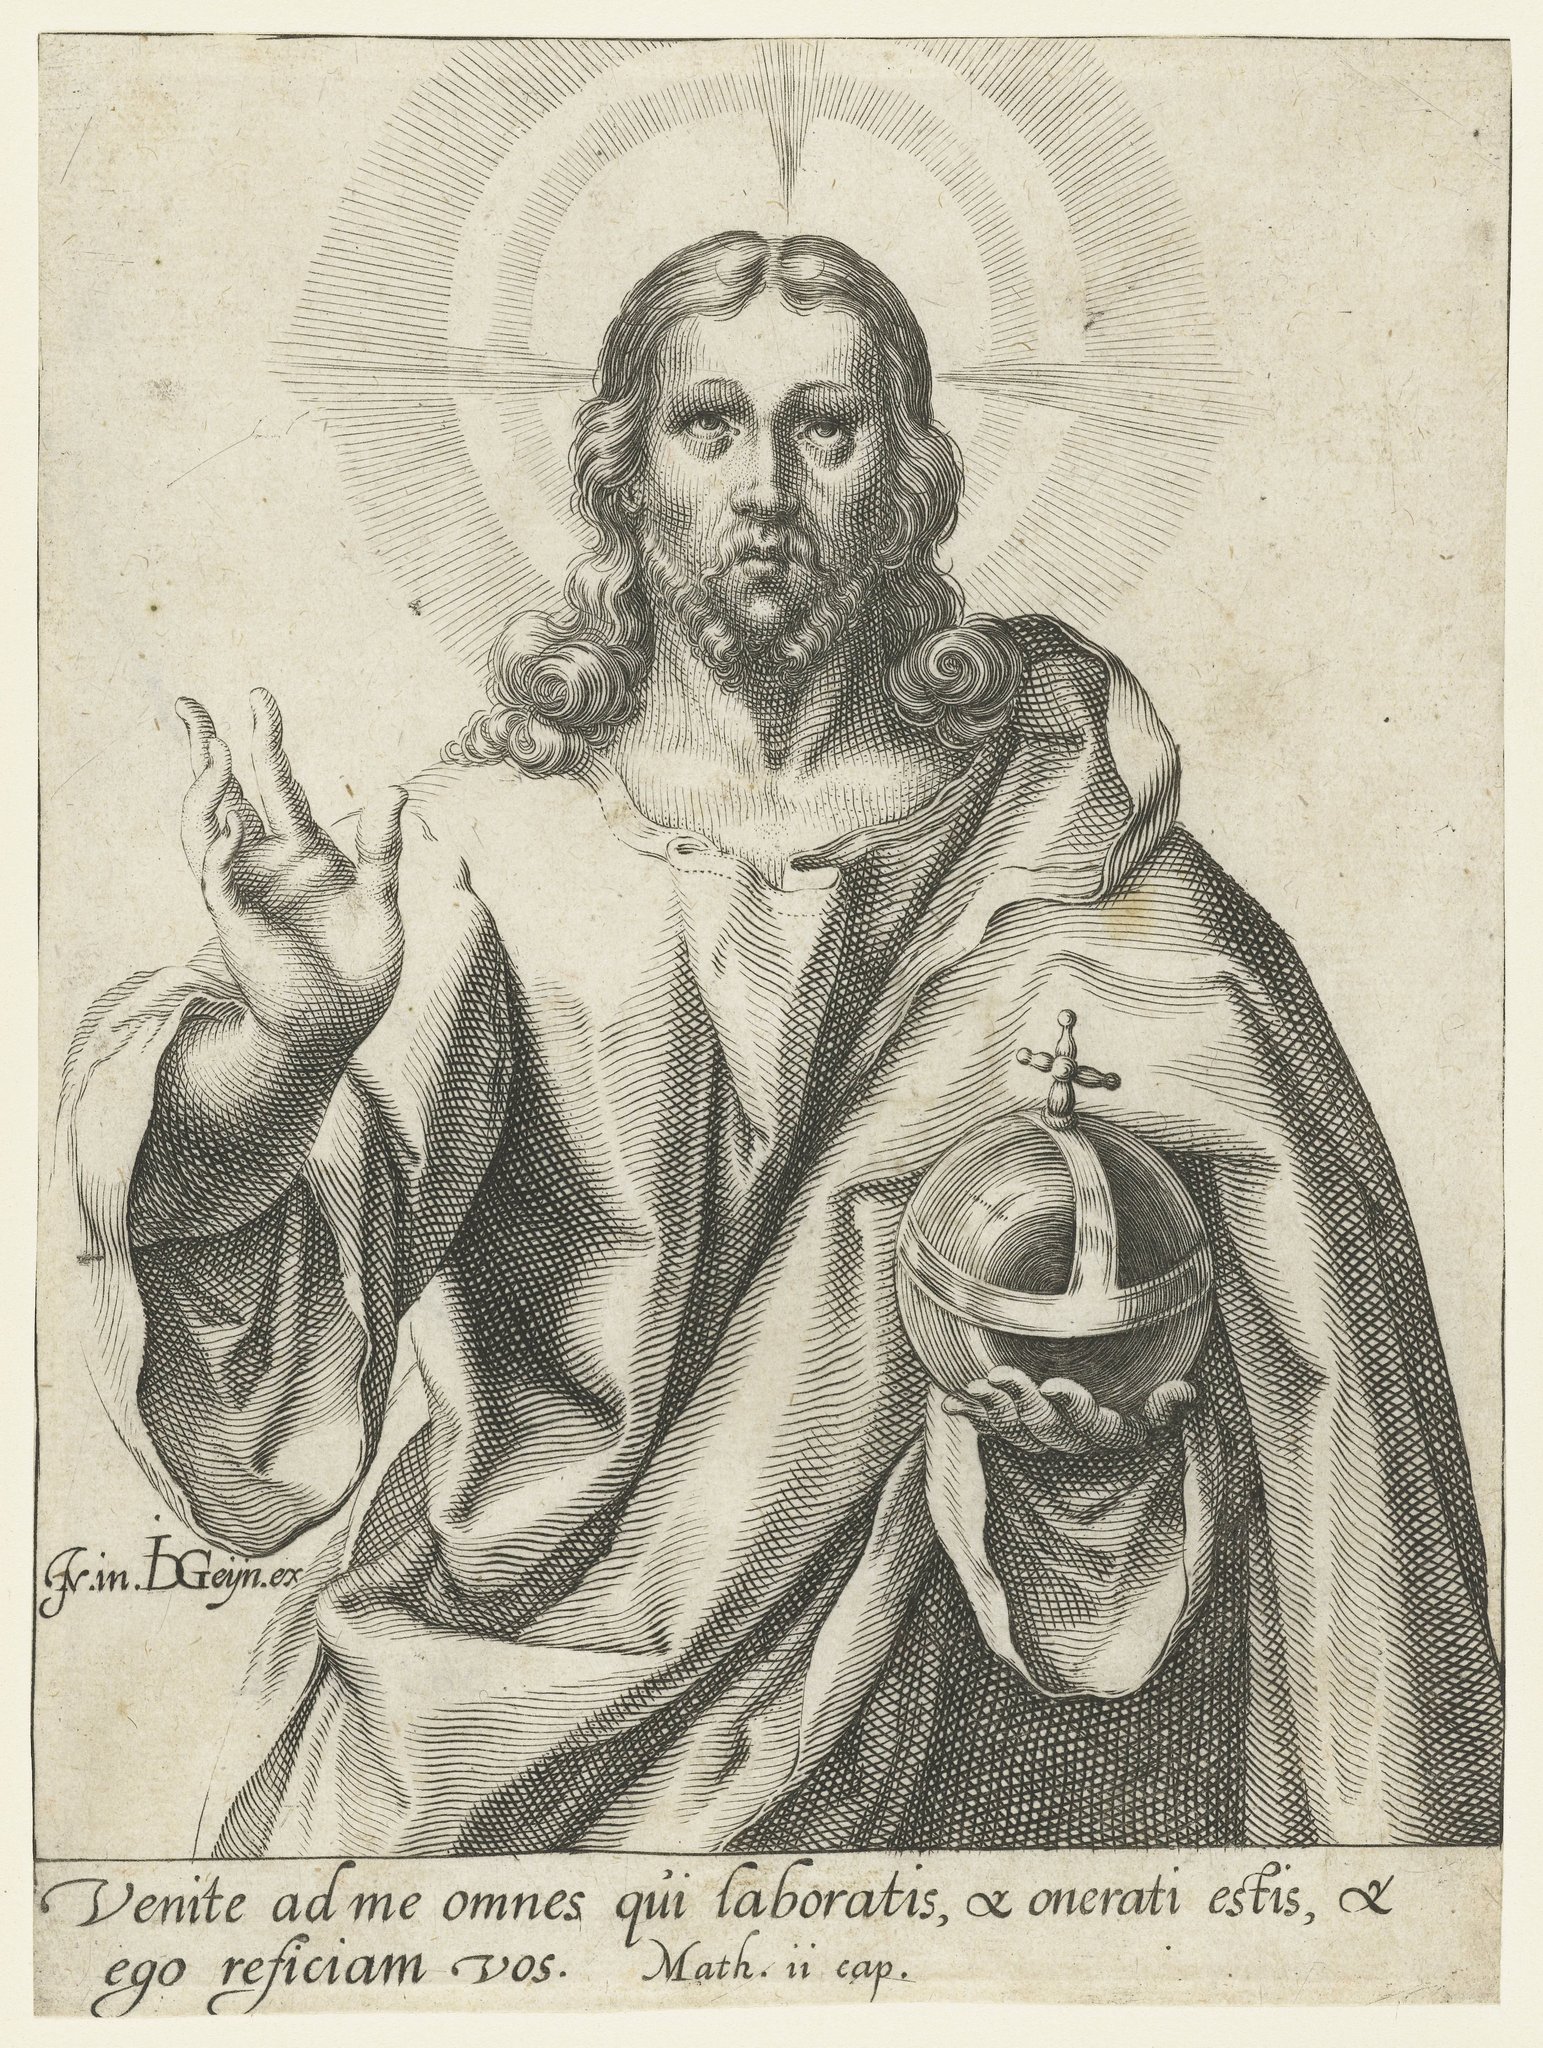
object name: print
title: Christus als Salvator Mundi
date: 1593-1597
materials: paper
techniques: engraving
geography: netherlands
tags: 'salvator mundi', making a blessing gesture; an orb in his hand or at his feet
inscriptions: caption: ‘Venite ad me omnes qui laboratis, onerati estis, ego reficiam vos. Math. ii cap.’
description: Christus, ten halven lijve, de rechterhand opgeheven, in de linkerhand een rijksappel. Onder de voorstelling twee regels Latijnse tekst (Mattheüs 11: 28).